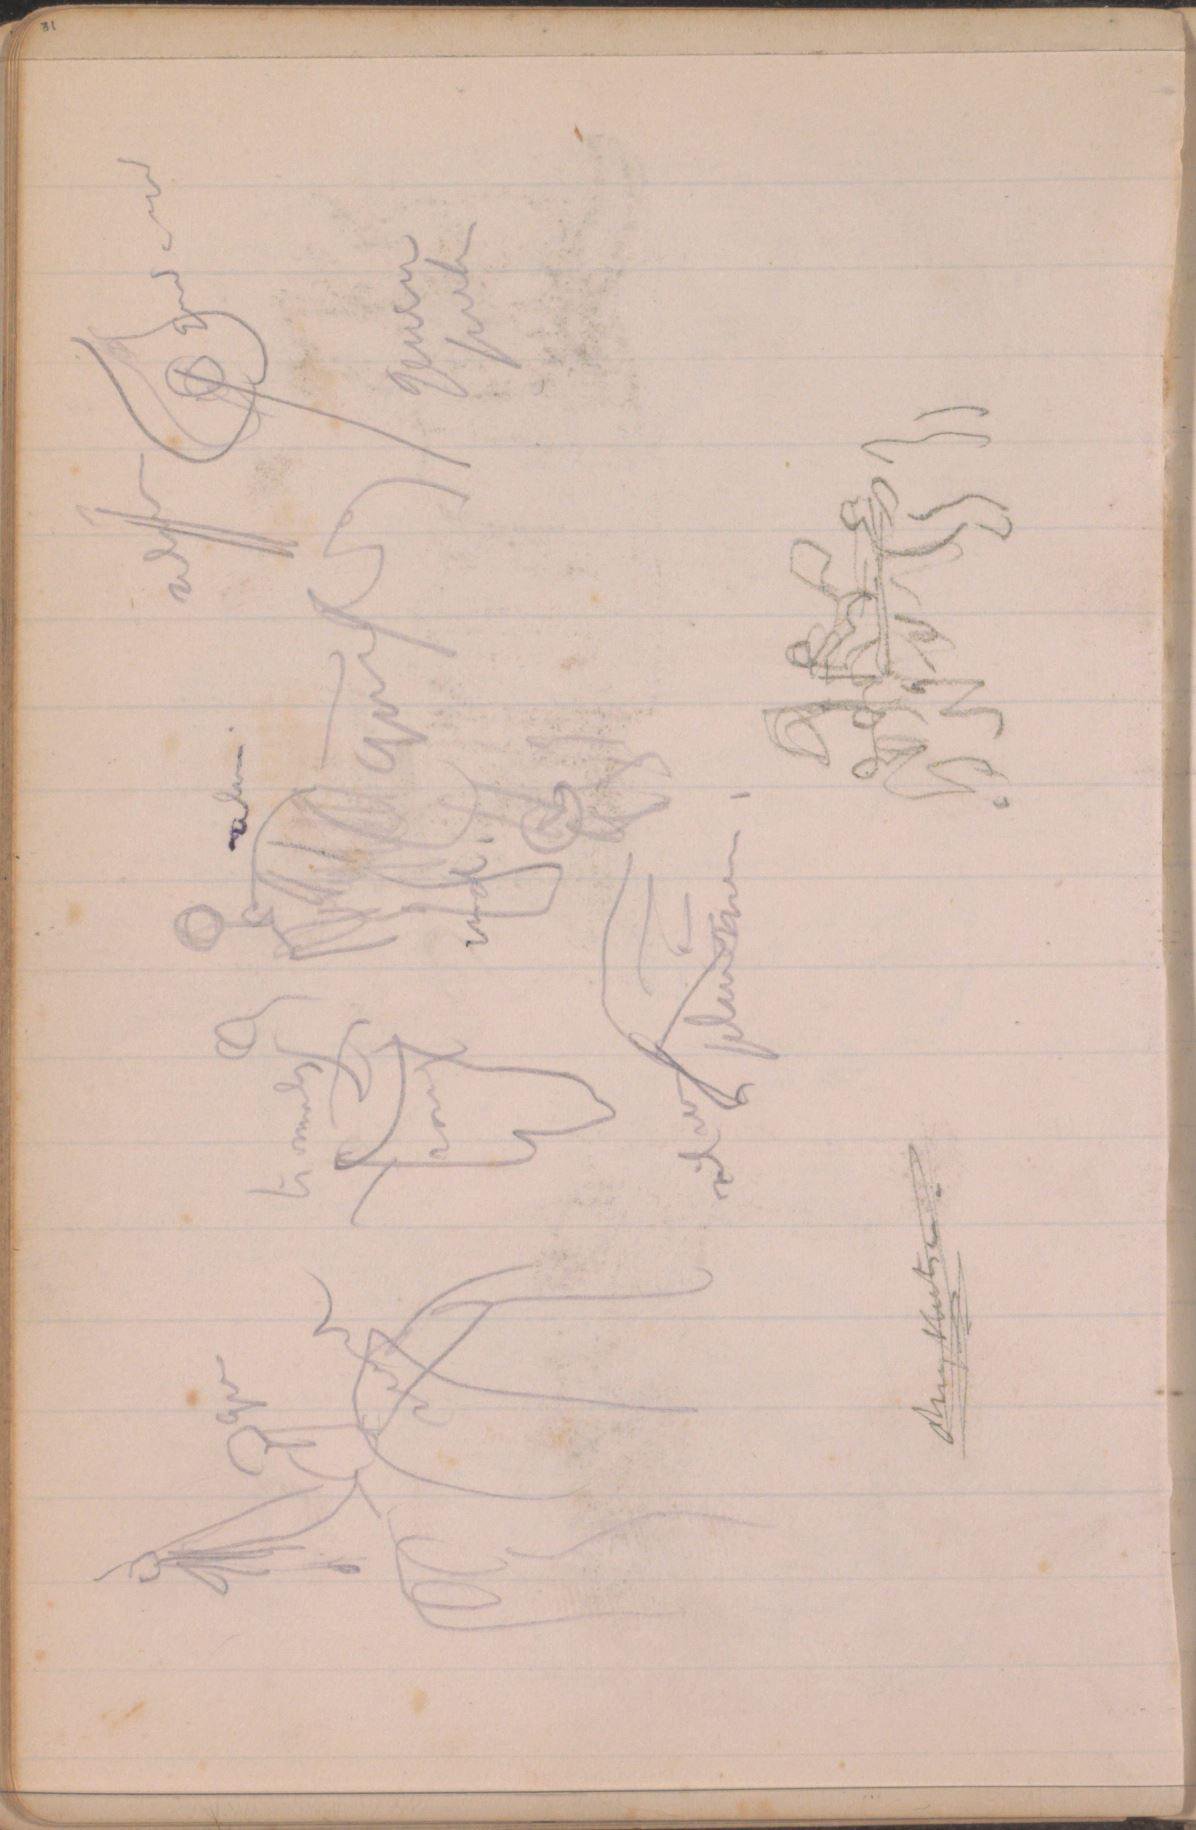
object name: sketchbook leaf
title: Figuren, onder andere op een olifant en een draagstoel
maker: marius bauer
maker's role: draughtsman, print maker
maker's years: 1867-1932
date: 1897-1898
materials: pencil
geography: india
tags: (carrying a person in a) sedan-chair, asiatic races and peoples: indians, trunked animals: elephant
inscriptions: kleurnotitie, handgeschreven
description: Pagina 31 uit een schetsboek met 84 bladen.